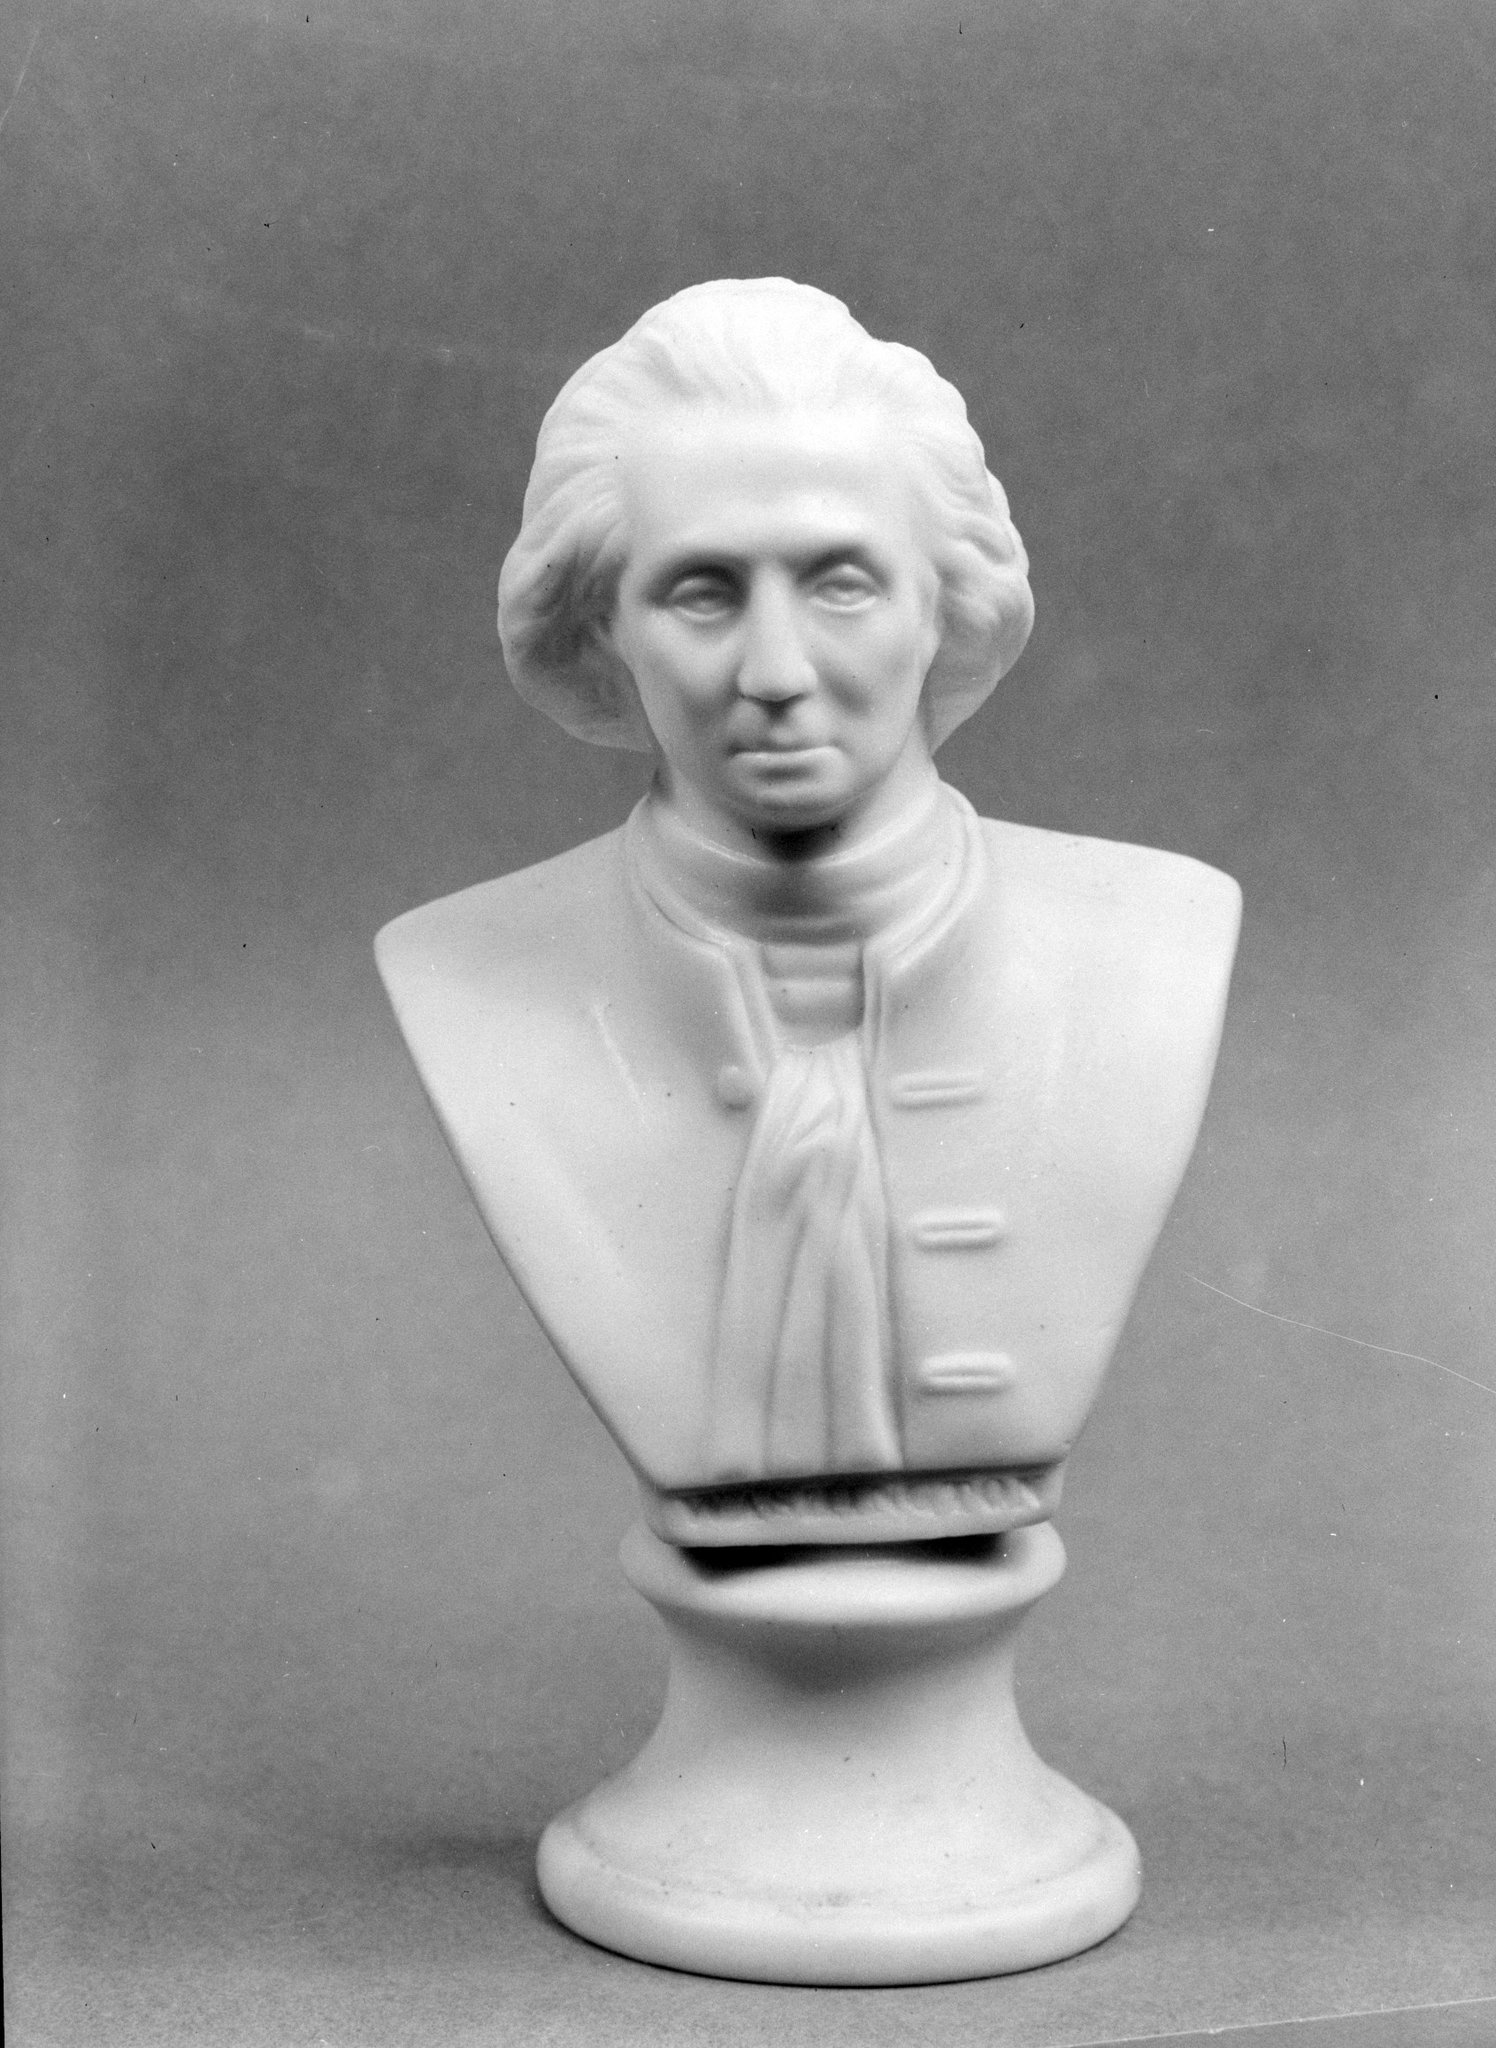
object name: bust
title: Bust of George Washington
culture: american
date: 1830-1870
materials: porcelain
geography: united states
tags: george washington,portraits